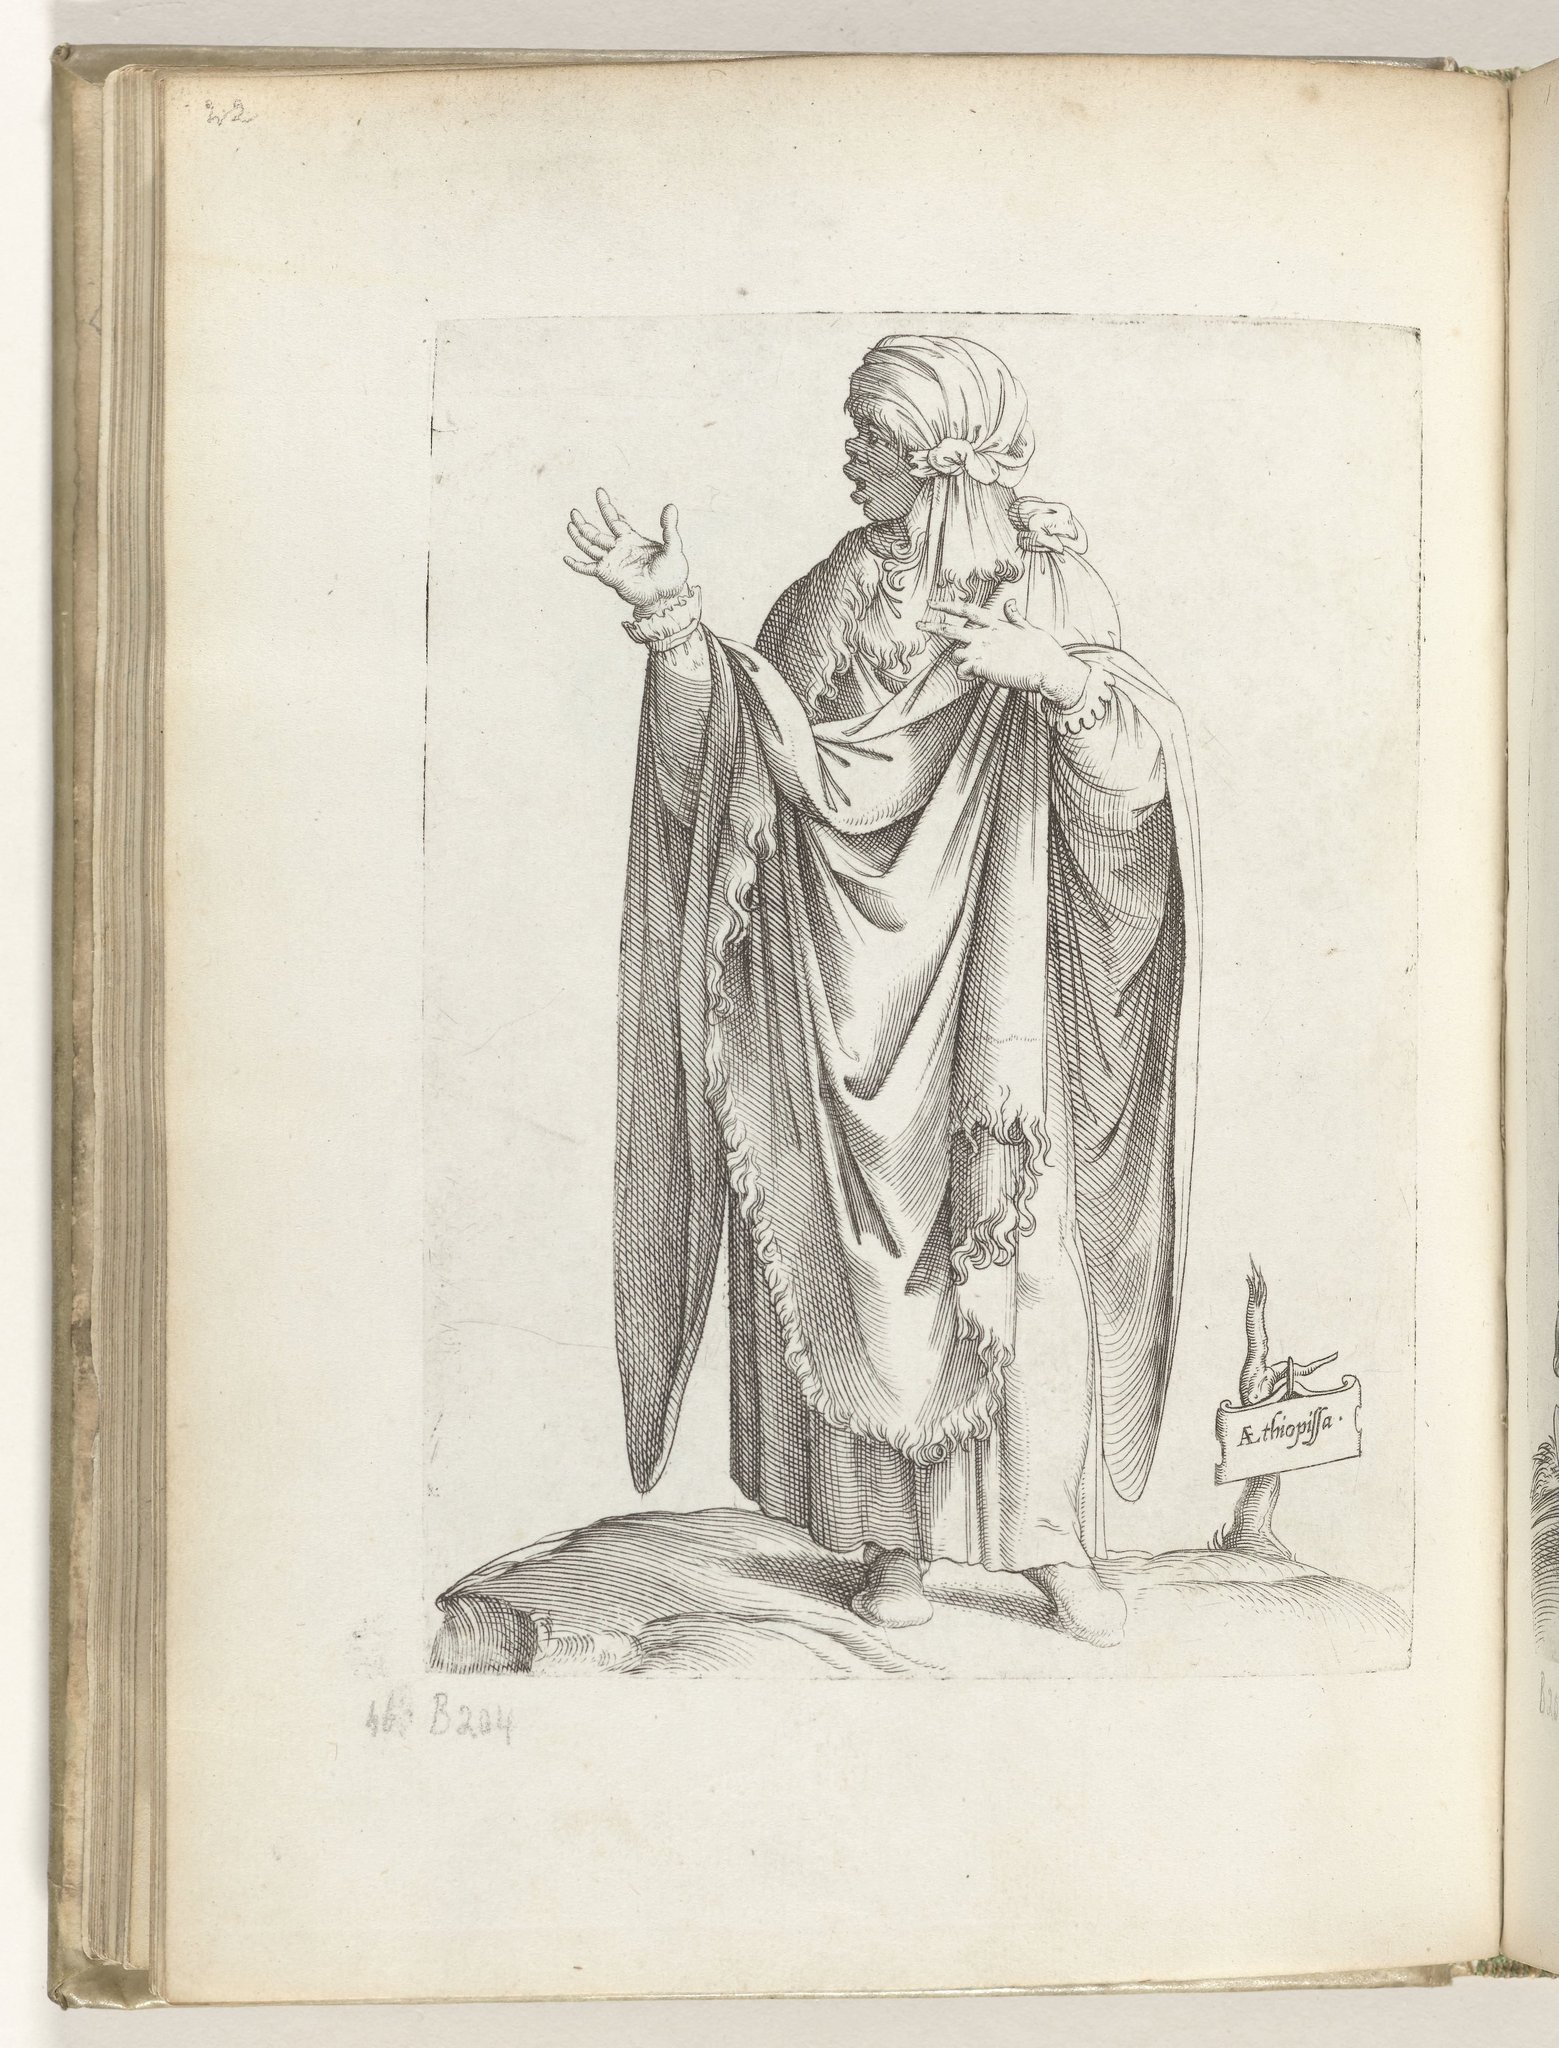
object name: costume print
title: Diversarum gentium nostrae aetatis habitus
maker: enea vico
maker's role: draughtsman, print maker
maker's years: 1523-1567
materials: paper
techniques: engraving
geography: venice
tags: africans (+ costume), fashion plates, head-gear: turban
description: Vrouw uit Ethiopië. Prent uit album 'Diversarum gentium nostrae aetatis habitus'.